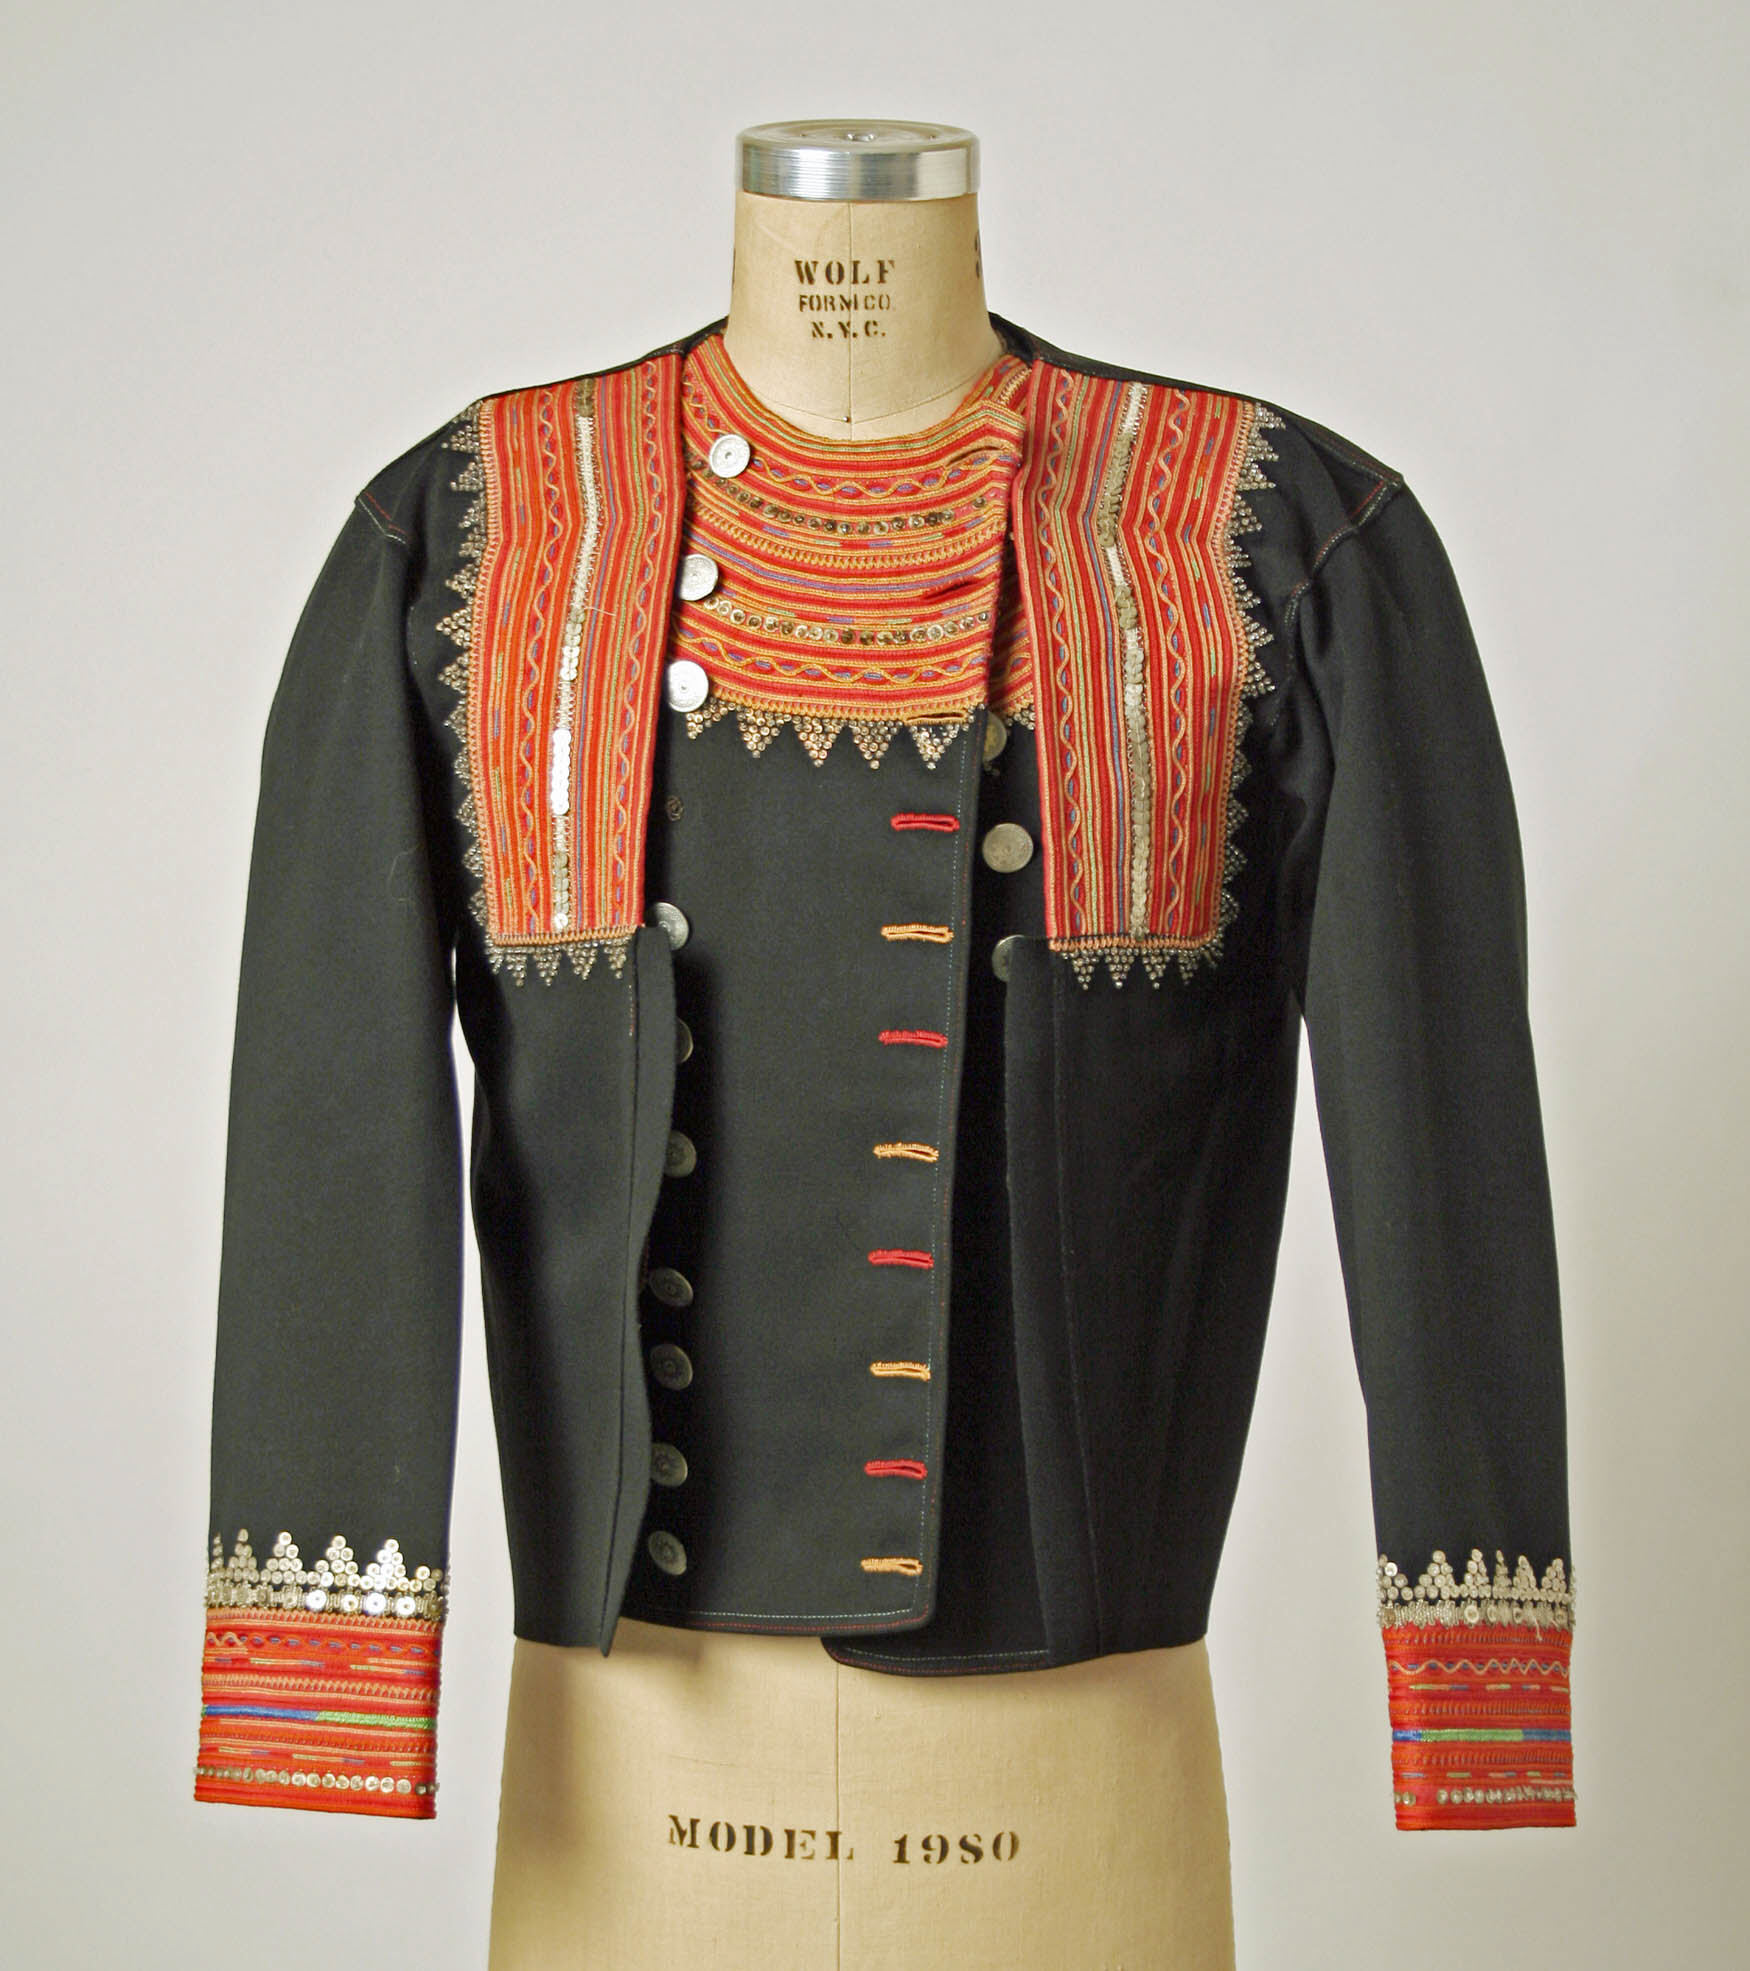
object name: jacket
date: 1867-1900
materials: glass, metal, wool